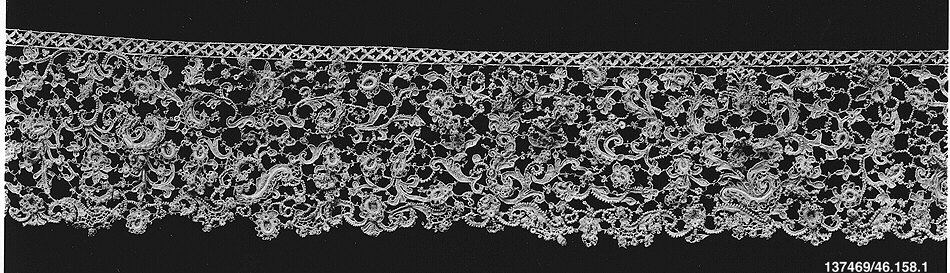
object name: border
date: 1667-1700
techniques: lace